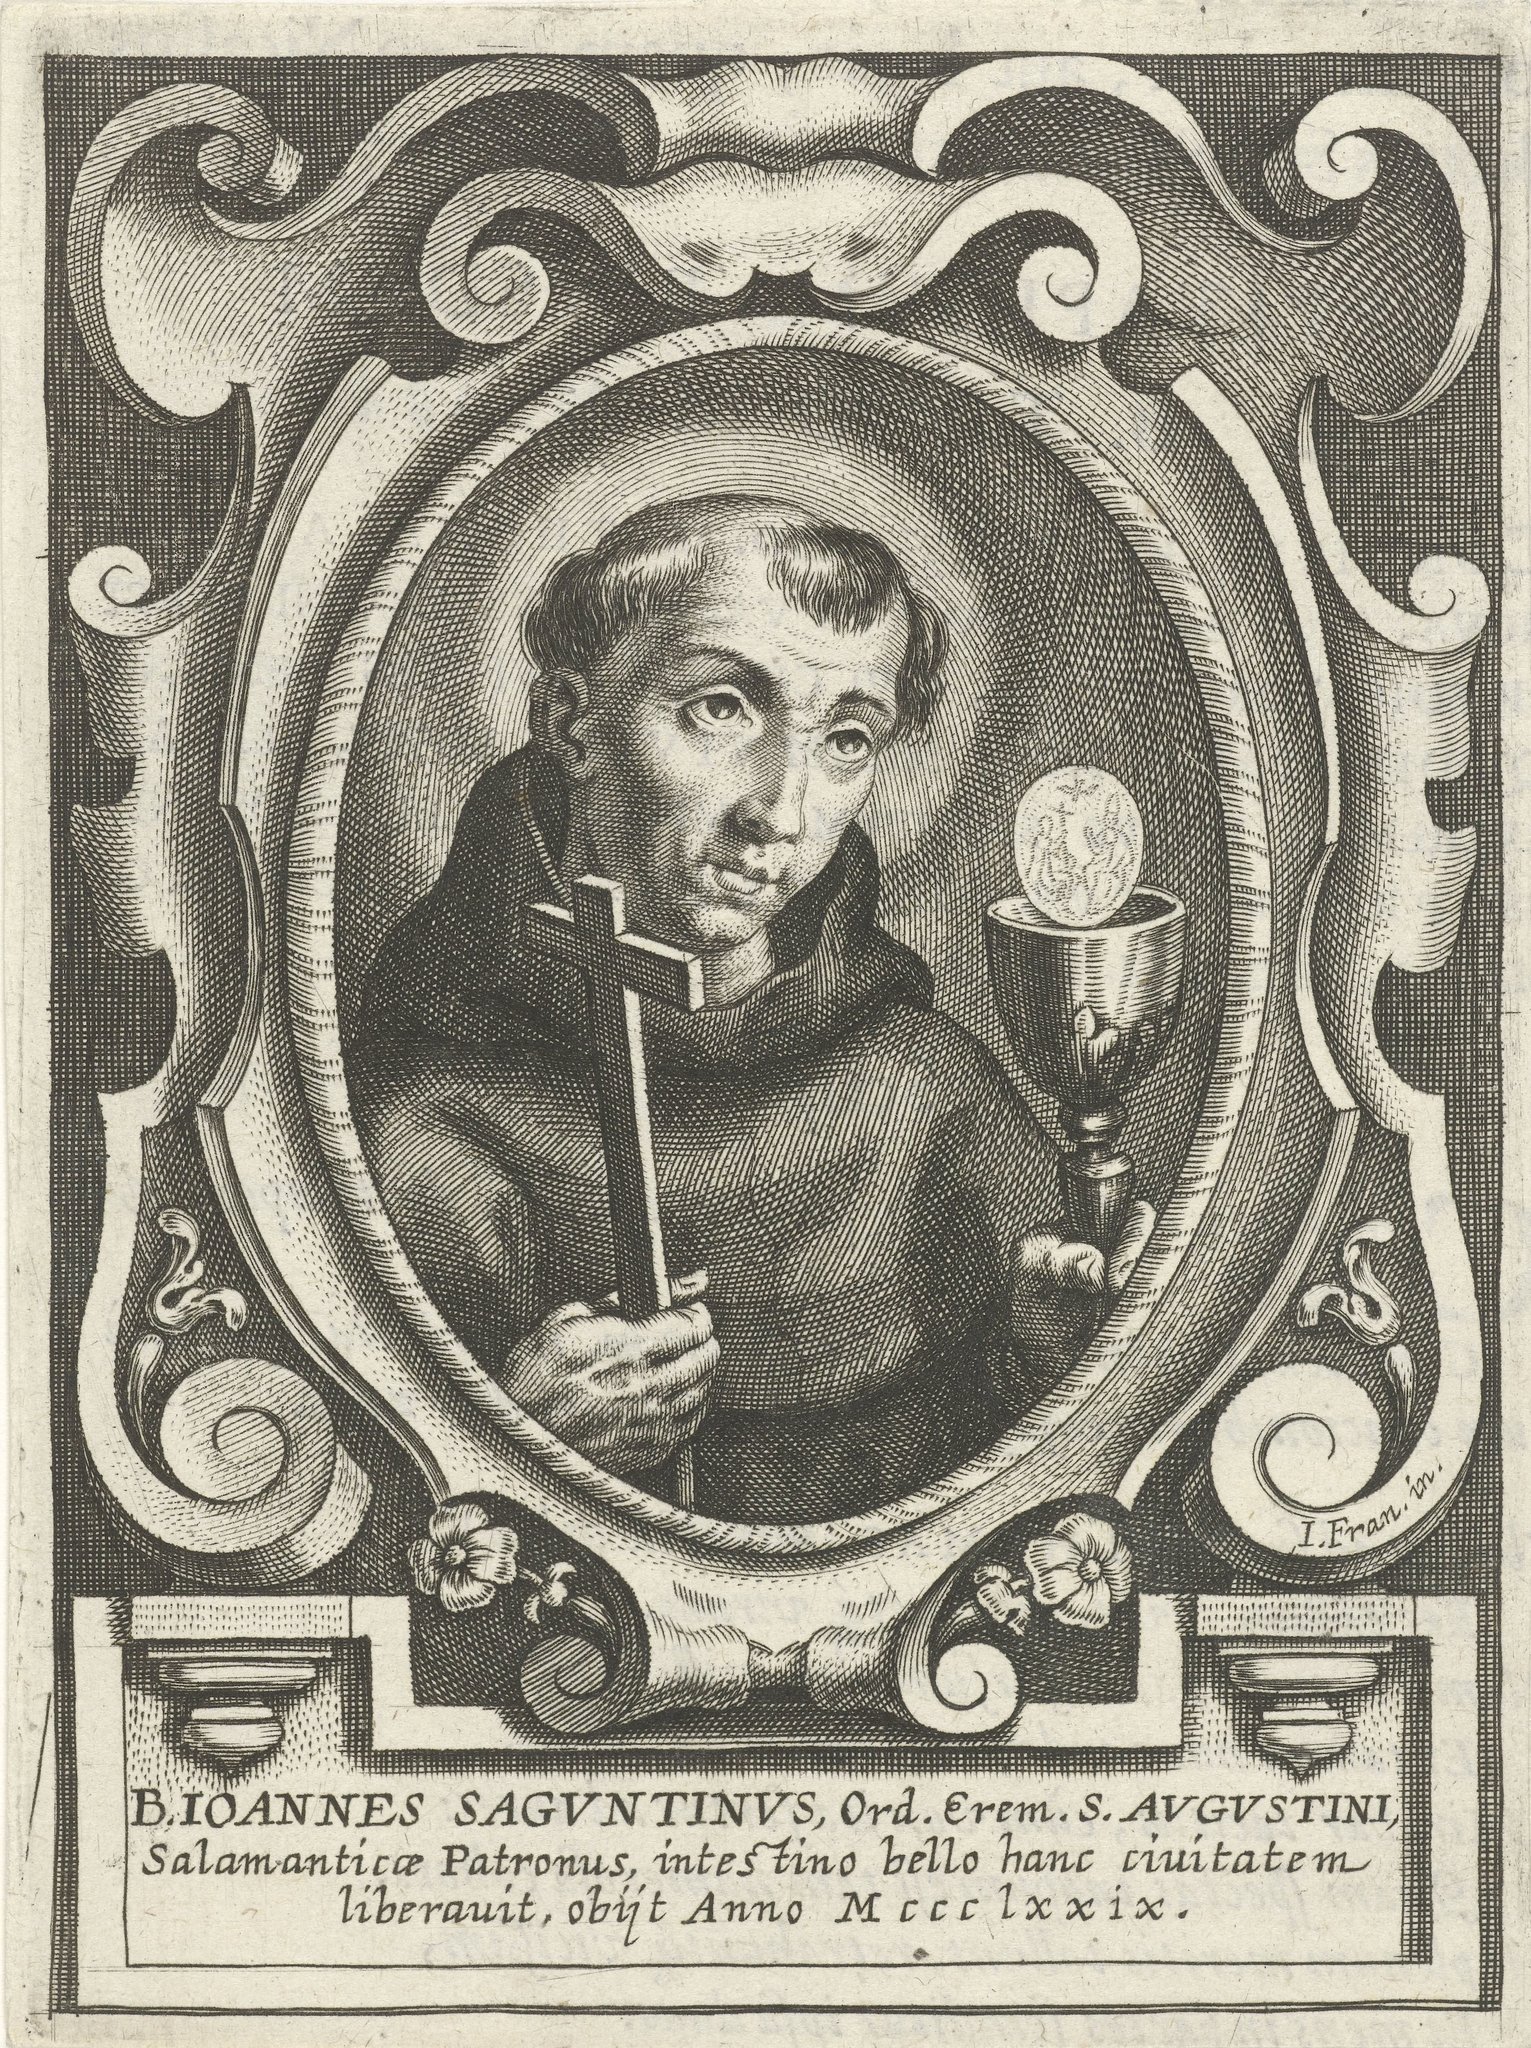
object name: book illustration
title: Portret van de Augustijn Johannes González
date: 1636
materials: paper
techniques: engraving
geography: southern netherlands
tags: monastic orders, monastic life ~ roman catholic church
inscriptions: collector's mark: Lugt 2228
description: Boekillustratie voor: C. Curtius, Virorum illustrium ex ordine Eremitarum D. Augustini elogia , Antwerpen: J. Cnobbaert, 1636.